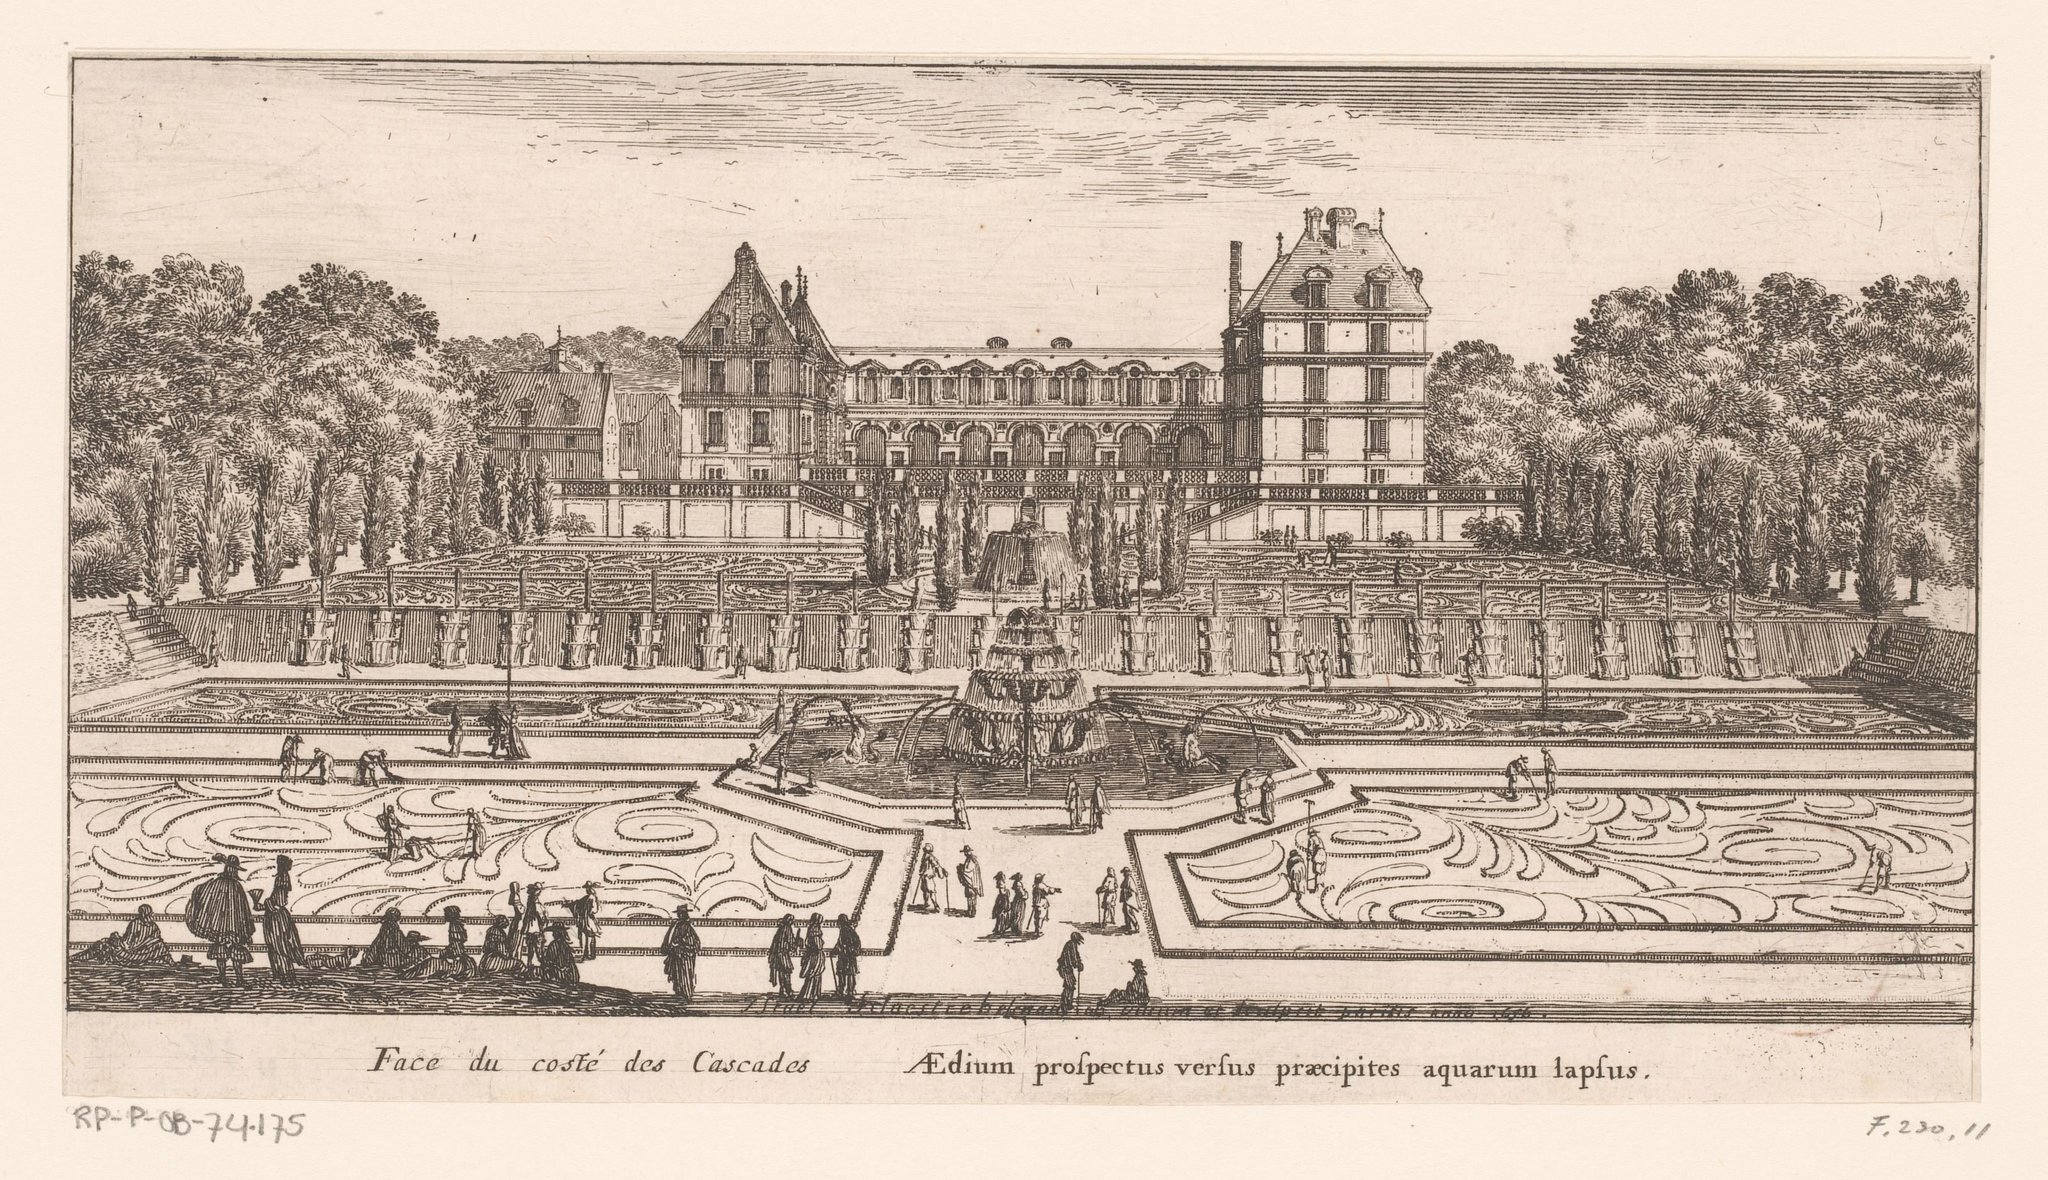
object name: print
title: Differentes veues du Chasteau et des Jardins, Fontaines, Cascades, Canaux et Parterres de Liencourt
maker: israël silvestre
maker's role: draughtsman, print maker, publisher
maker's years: 1621-1691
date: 1656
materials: paper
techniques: engraving, etching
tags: garden fountain, french or architectonic garden; formal garden, landscape with tower or castle, garden cascade, paris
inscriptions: collector's mark: Lugt 240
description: Prent maakt deel uit van een ongenummerde serie van twaalf prenten.